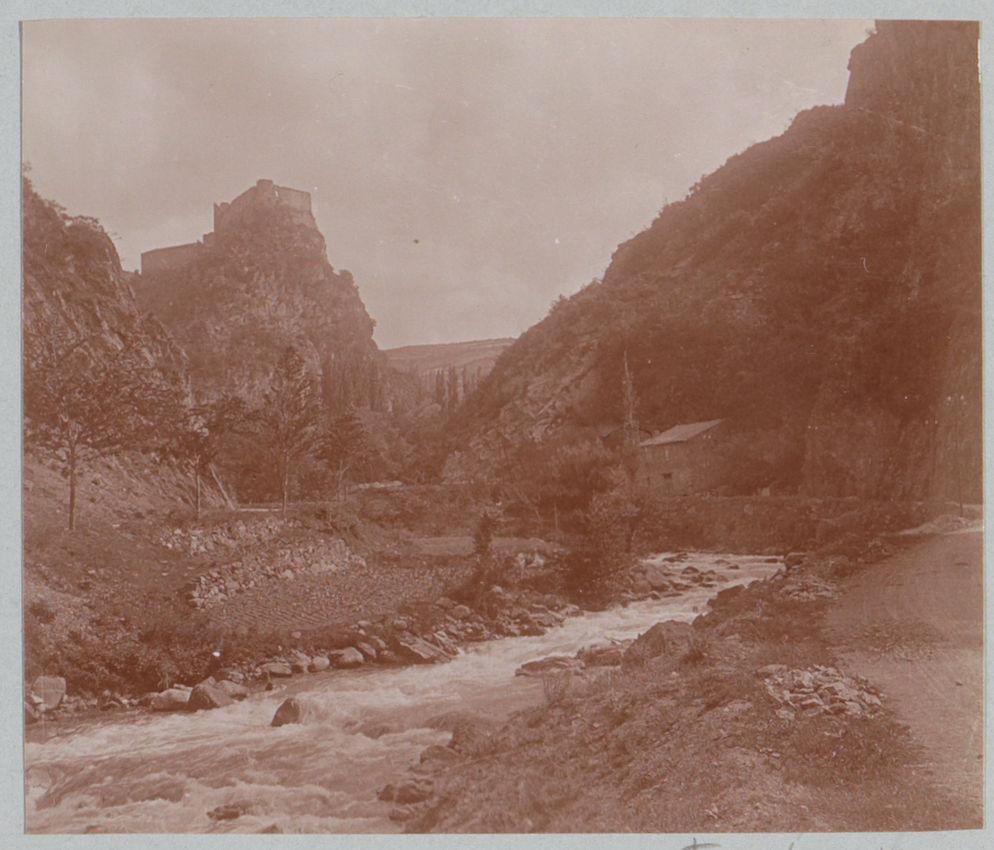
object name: photograph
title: Berglandschap met een beek en een kasteel op een rots, vermoedelijk in de Pyreneeën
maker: Anonymous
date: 1905-1910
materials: paper, photographic support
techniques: gelatin silver print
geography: pyrenees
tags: fortress, mountains (+ landscape with figures, staffage), river (+ landscape with figures, staffage)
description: Onderdeel van Fotoalbum van een Franse amateurfotograaf met bezienswaardigheden in Frankrijk, Zwitserland en Italië.